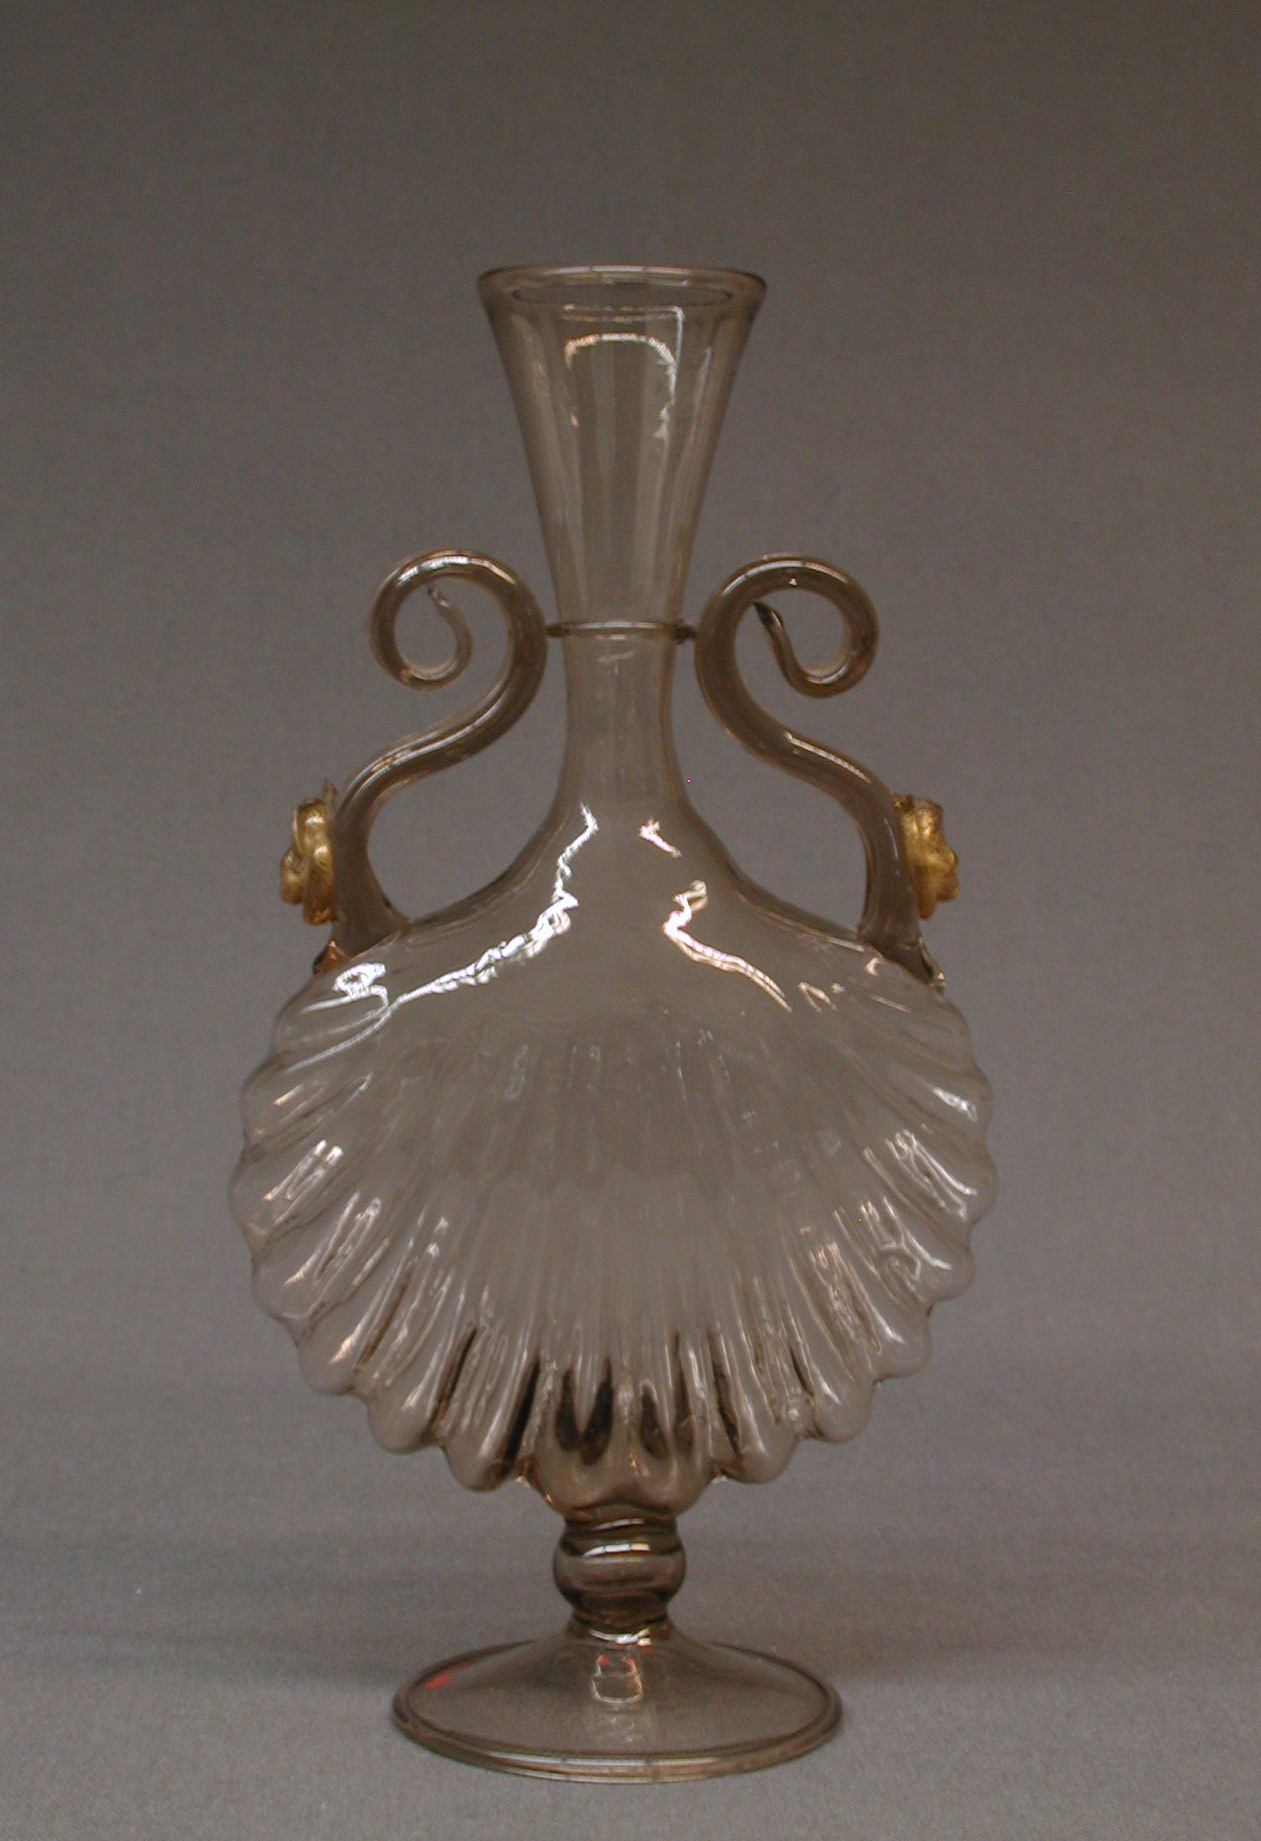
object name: vase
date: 1801-1900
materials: glass